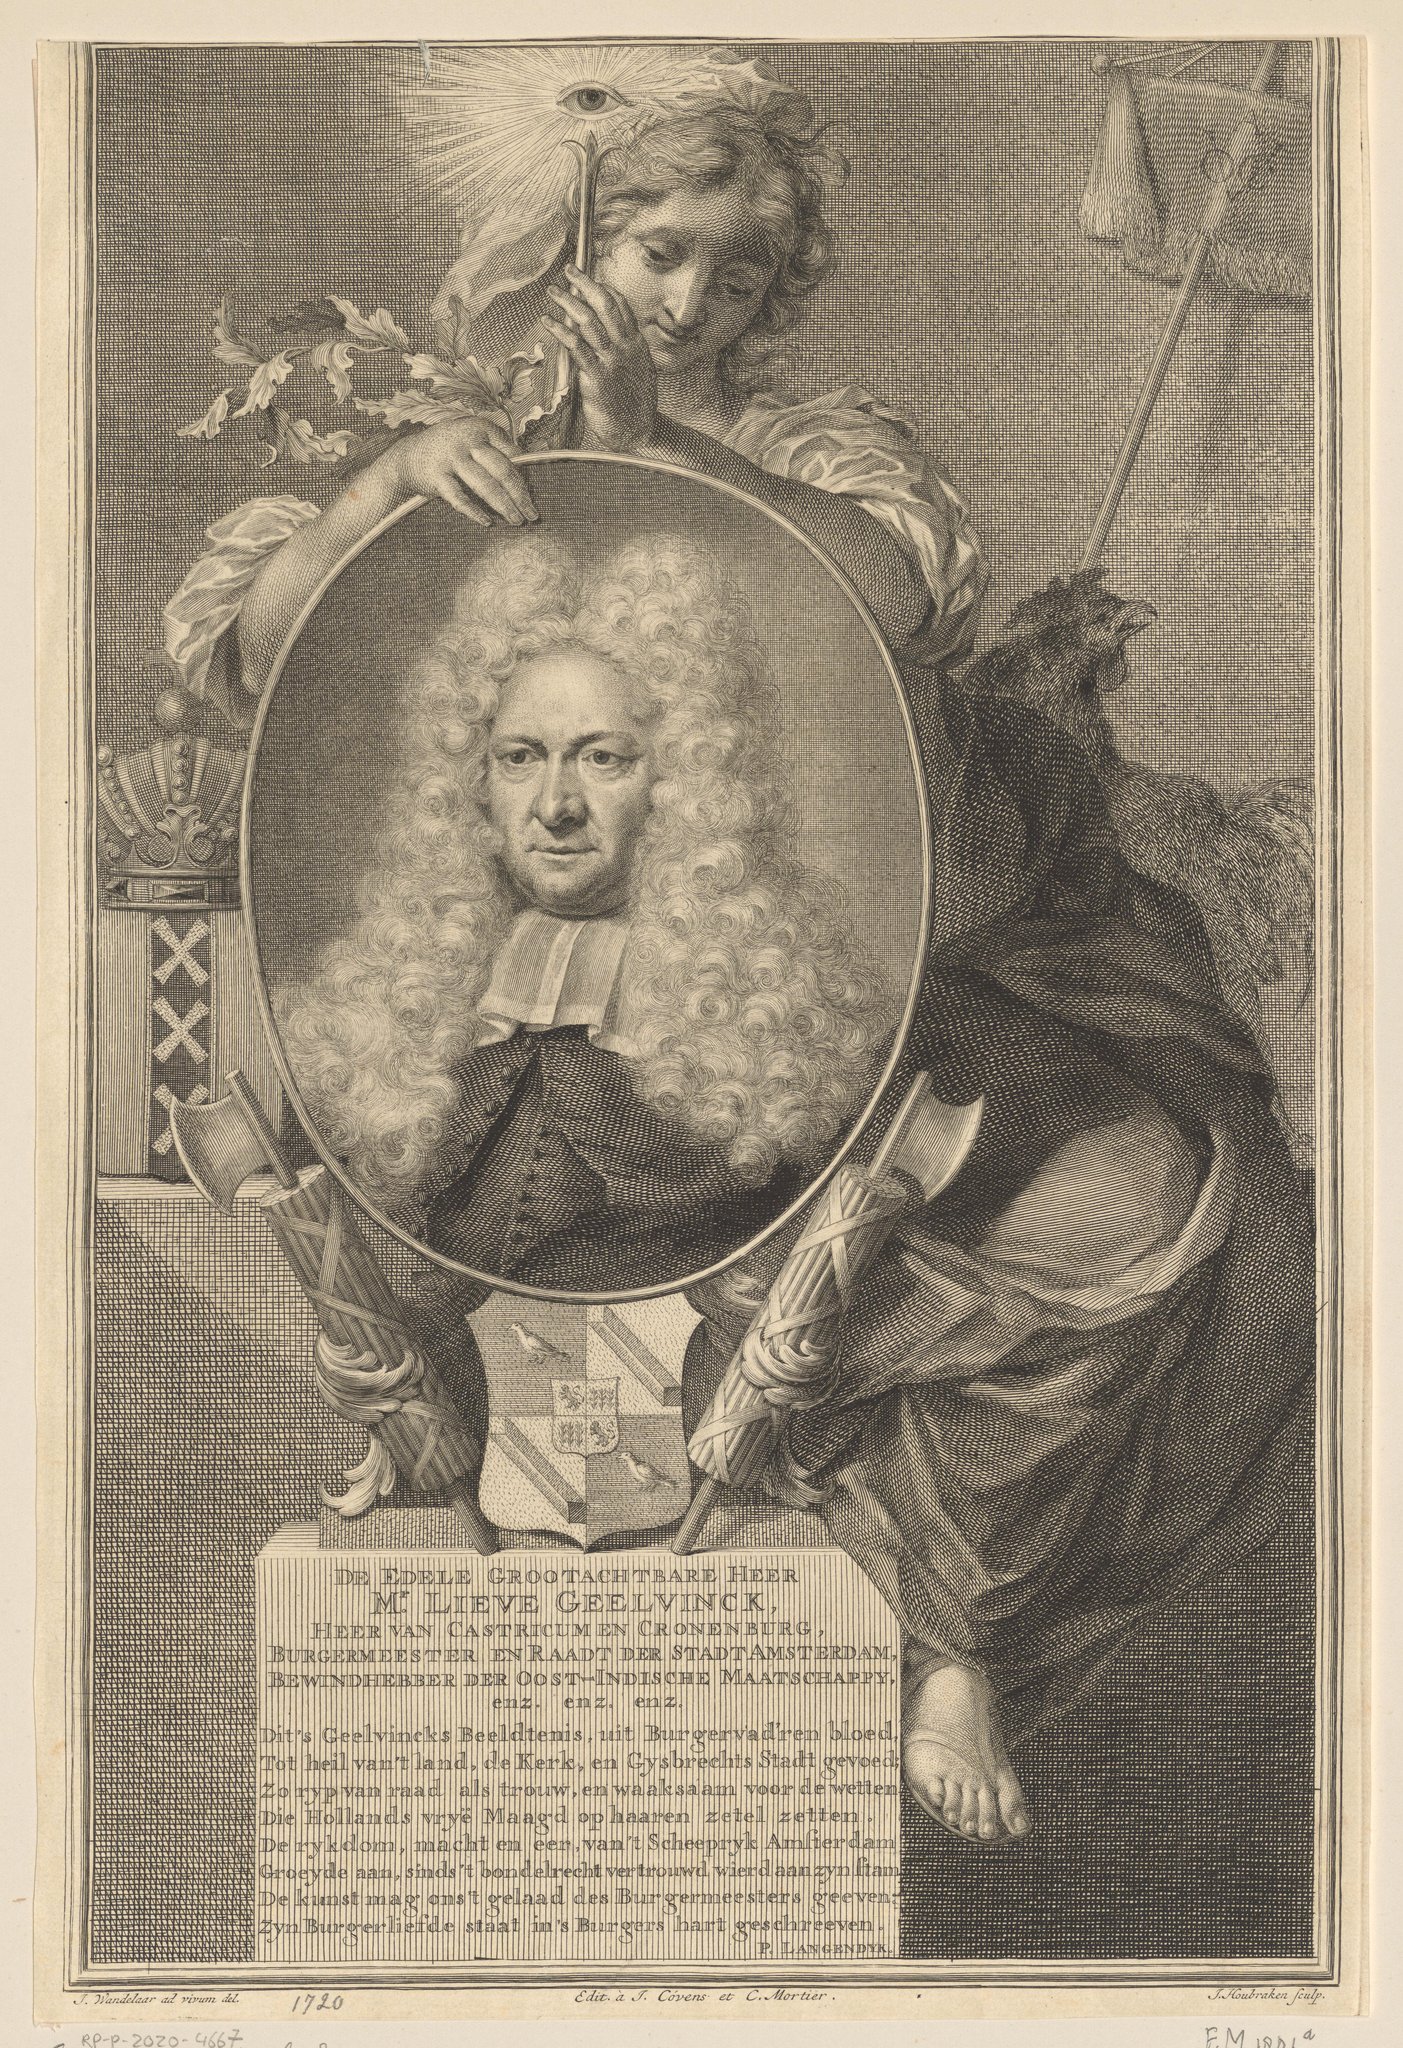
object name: print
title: Portret van Lieve Geelvinck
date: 1720-1770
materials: paper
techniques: engraving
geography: amsterdam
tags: lieve geelvinck, mayor, burgomaster, historical persons, the all-seeing eye, triangle with eye ~ symbol of god the father (+ variant), alertness, vigilance; 'guardia', 'vigilanza', 'vigilanza per difendersi & oppugnare altri' (ripa) (+ abstract concept represented by female figure)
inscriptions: collector's mark: Lugt 12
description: Het medaillon wordt vastgehouden door de personificatie van Waakzaamheid met een staf met daarop het Alziend Oog. Achter haar een haan. Op het sokkel het wapenschild van de familie (o.a. twee geelvinken) met aan weerszijden fasces. Achteraan de vlag van de Verenigde Oost-Indische Compagnie. Tekst in het Nederlands in de ondermarge.